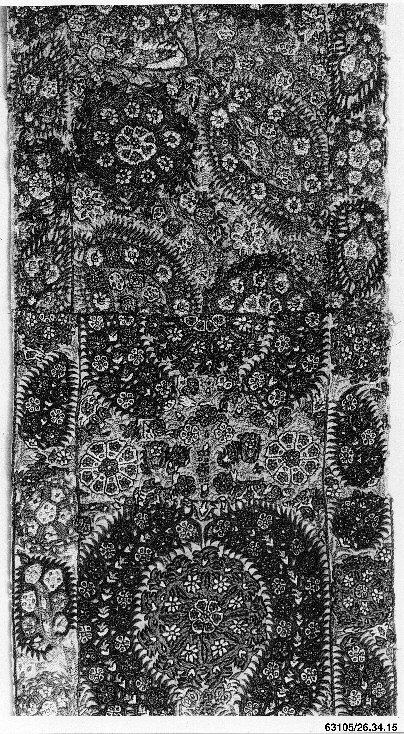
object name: strip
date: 1601-1800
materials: cotton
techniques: embroidery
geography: greece